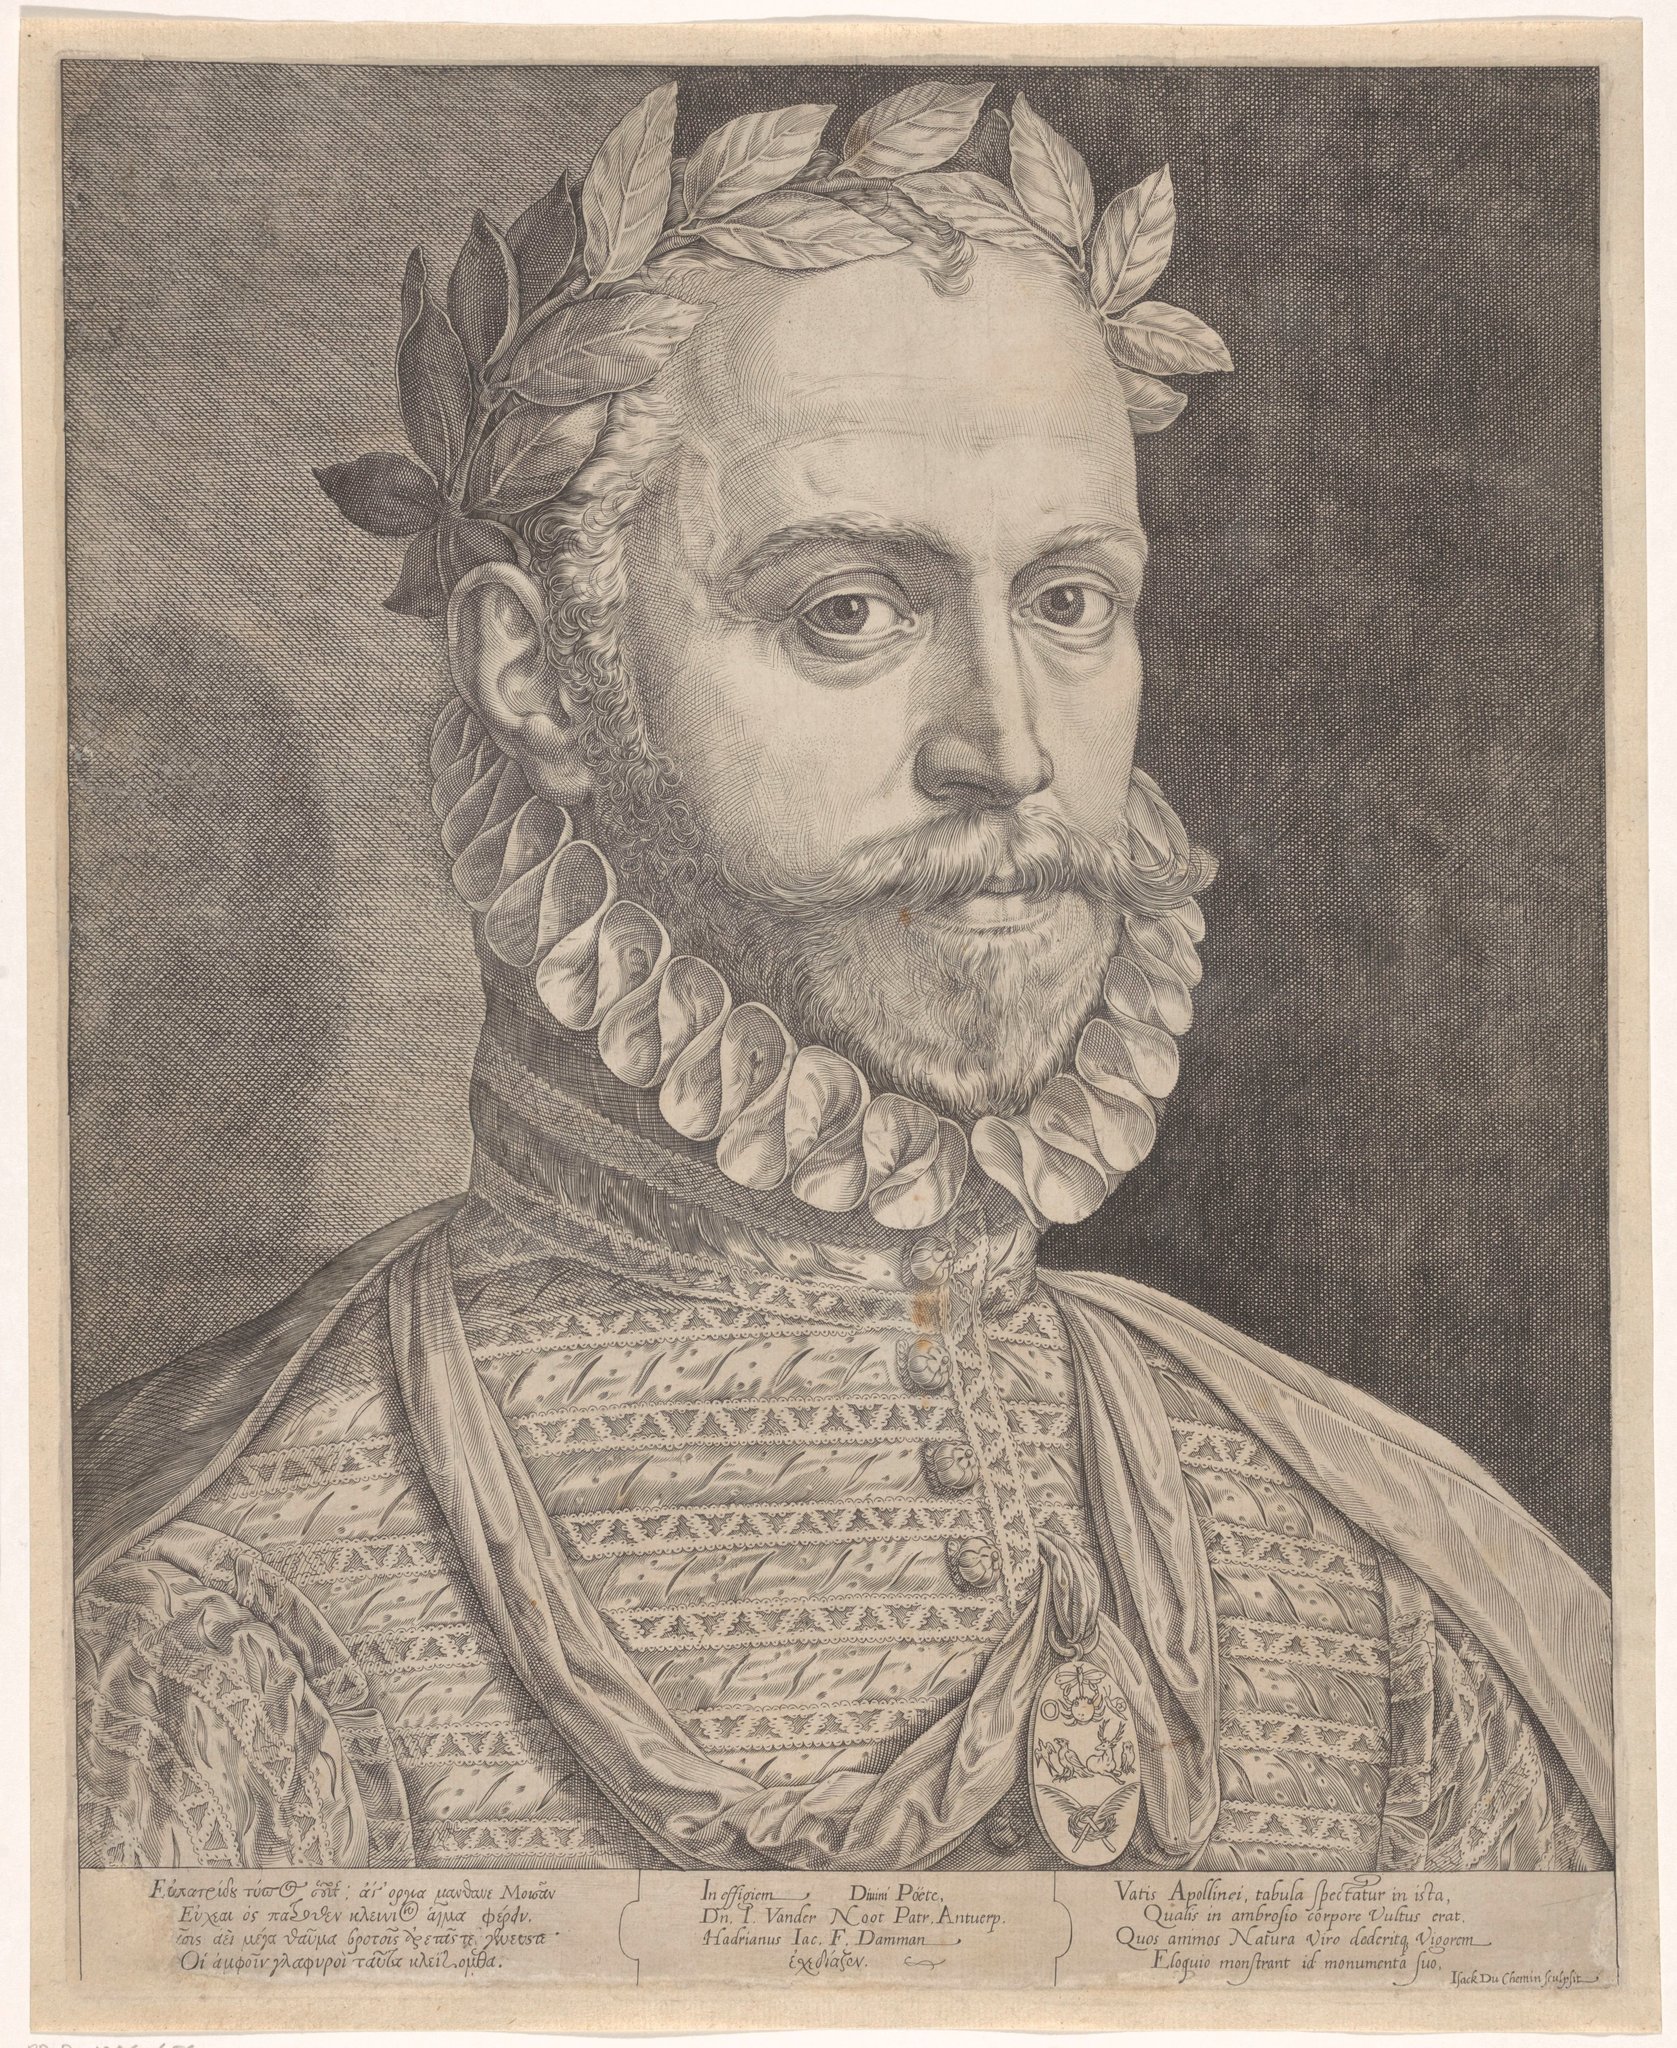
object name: print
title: Portret van de dichter Jan Baptista van der Noot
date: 1550-1599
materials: paper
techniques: engraving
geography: brussels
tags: writer, poet, author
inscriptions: collector's mark: Lugt 2228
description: Auteursportret van de dichter Jan van der Noot met lauwerkrans en medaille. Onder het portret een vers in het Grieks en Latijn.